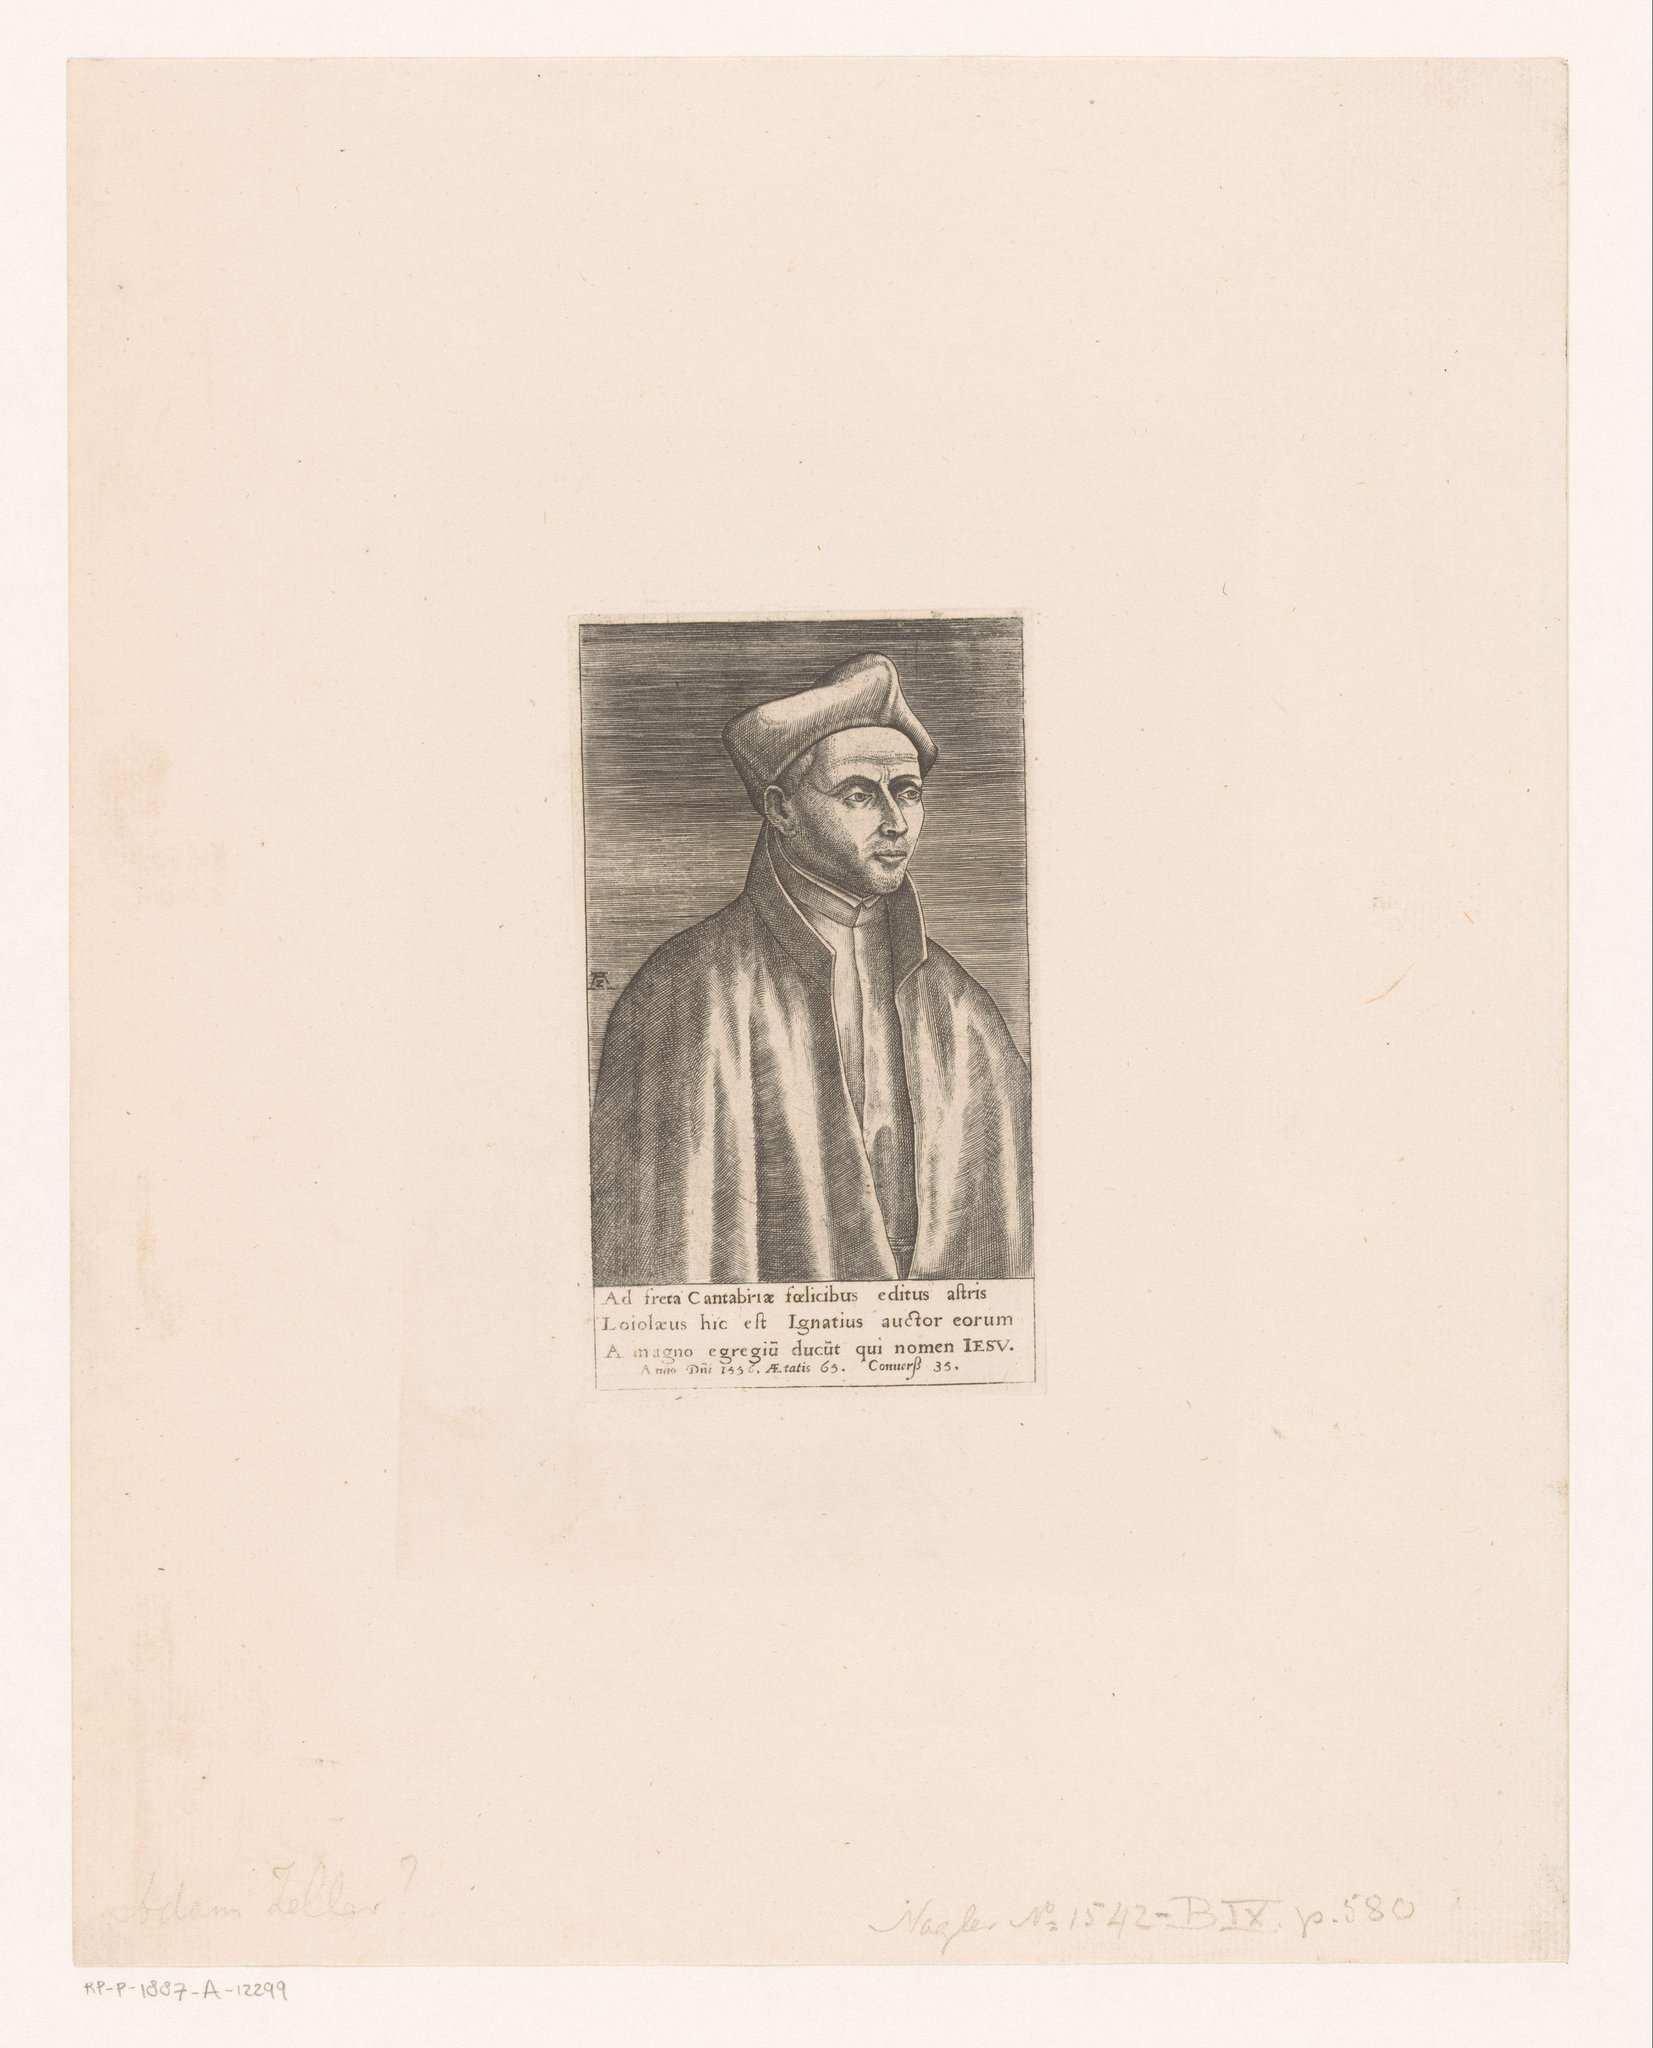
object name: print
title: Portret van Ignatius van Loyola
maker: adam zeller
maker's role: print maker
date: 1556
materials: paper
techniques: engraving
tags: clergyman, historical persons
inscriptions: collector's mark: Lugt 2228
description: Vierregelige Latijnse tekst in ondermarge.